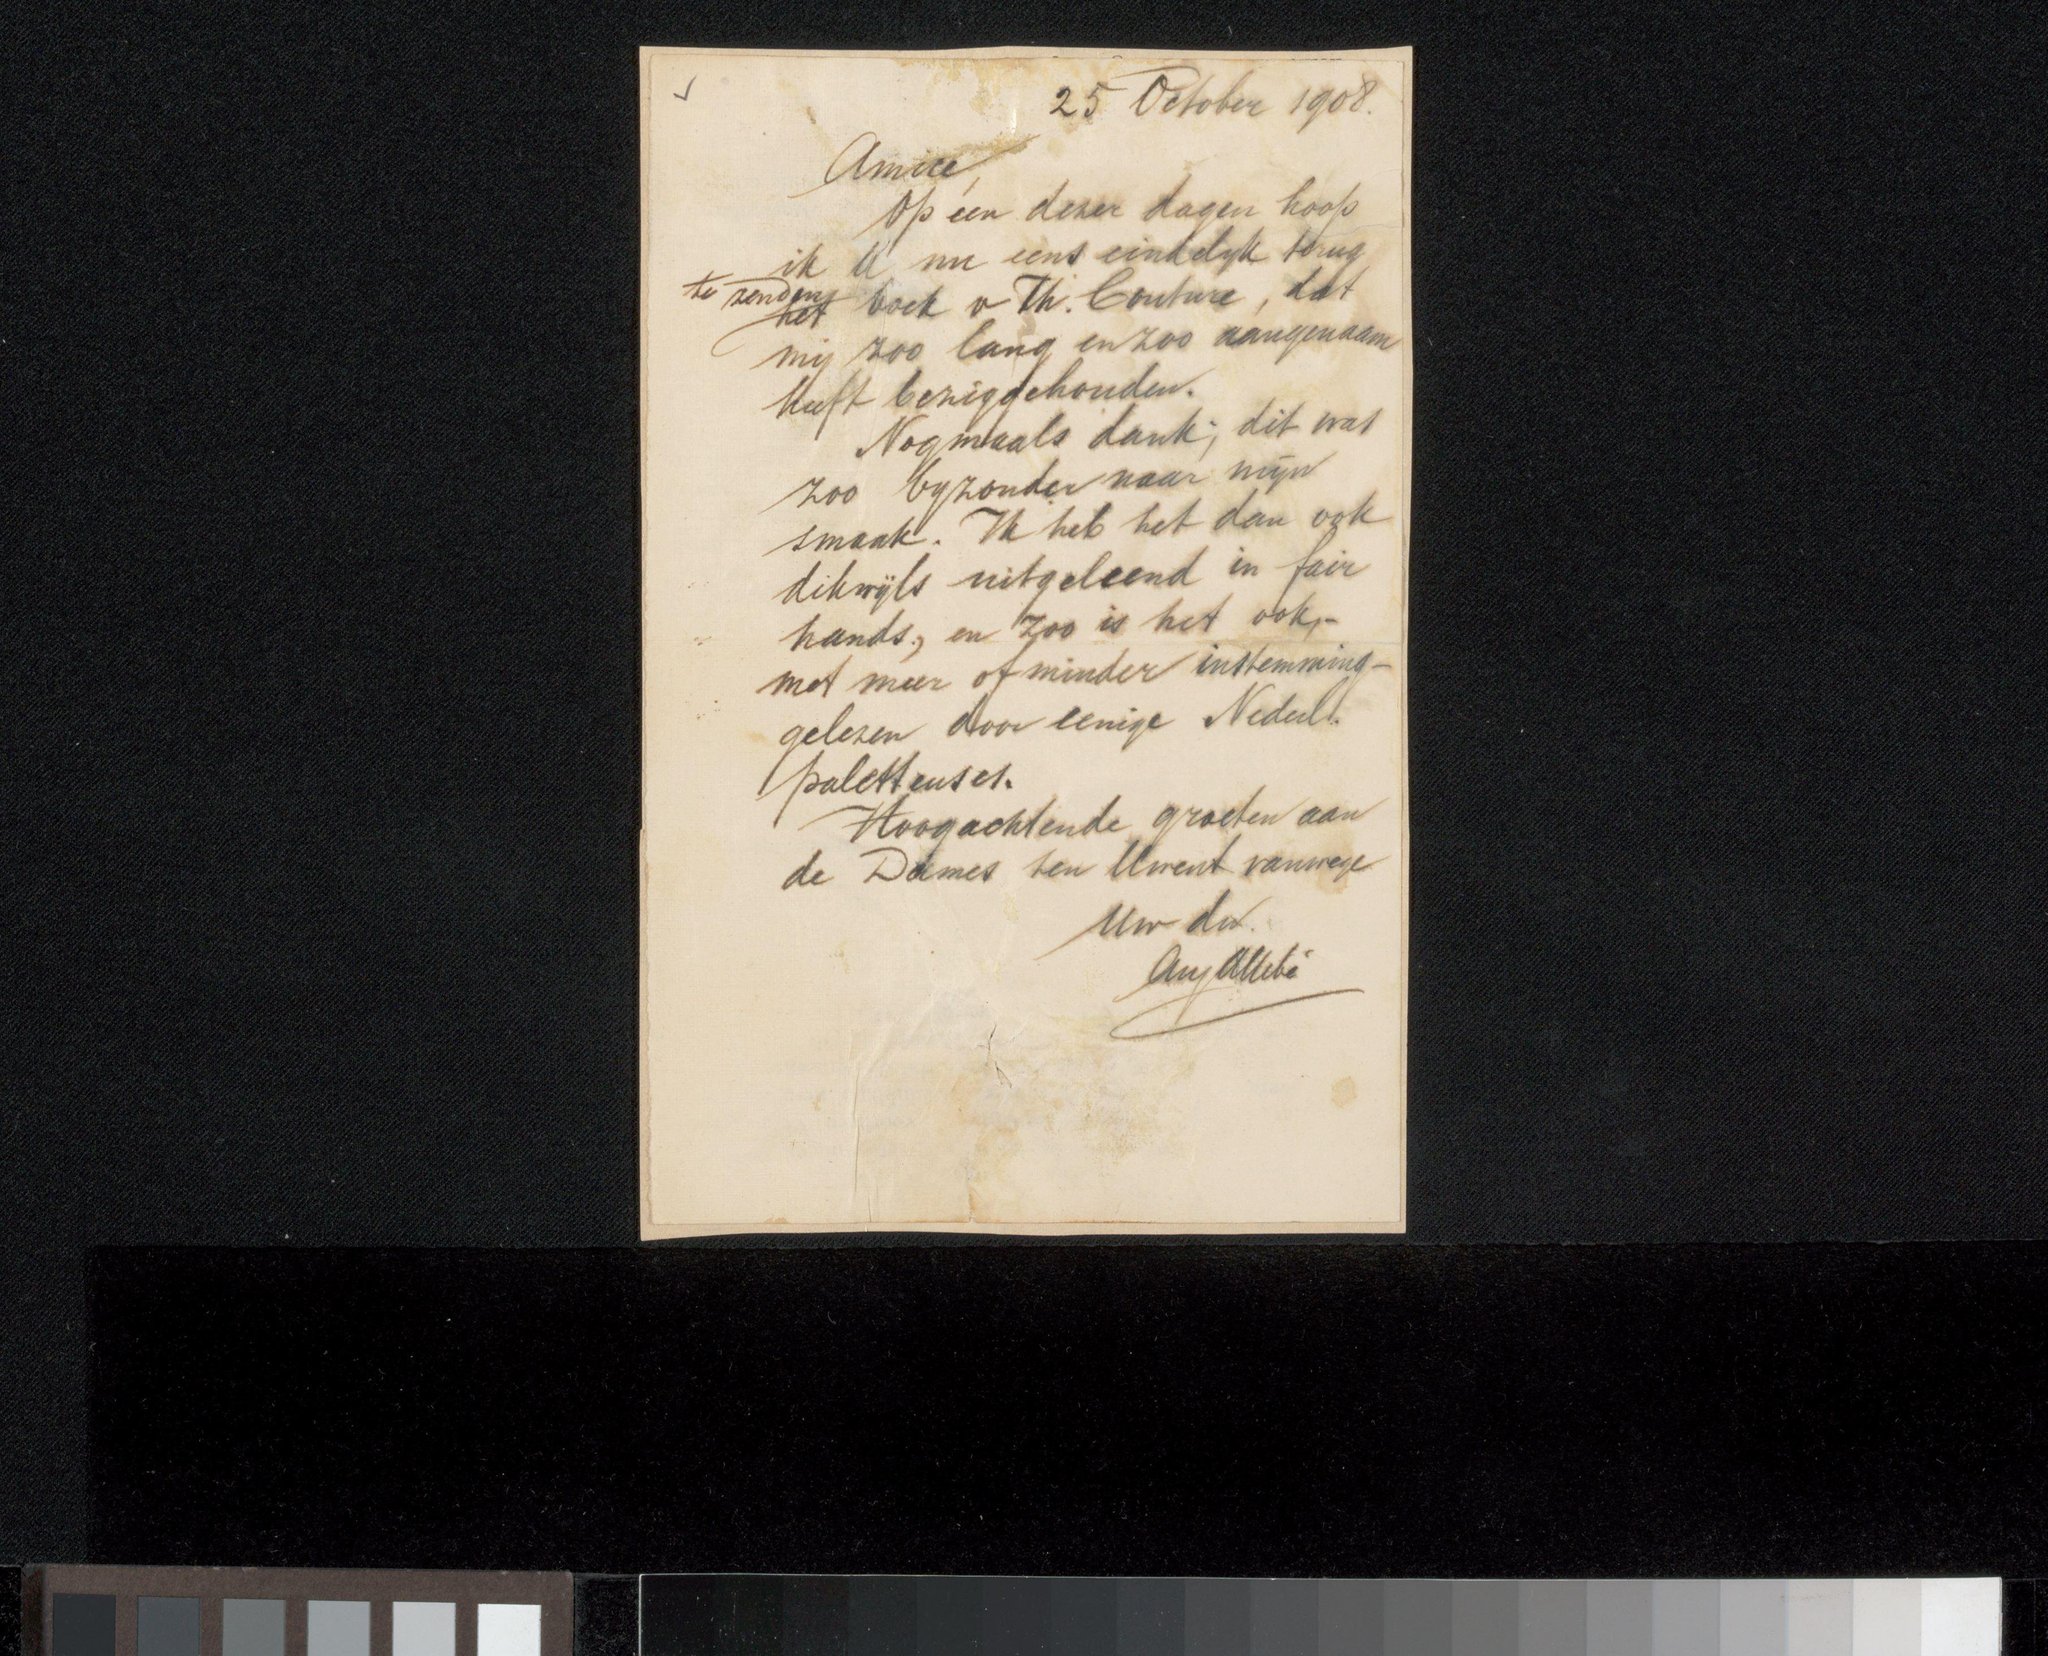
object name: letter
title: Brief aan Jan Veth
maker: august allebé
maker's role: draughtsman, print maker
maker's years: 1838-1927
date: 1908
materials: ink, paper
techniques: pen, writing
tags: dordrecht, painter, print maker, draughtsman, designer, jan veth, thomas couture, printed matter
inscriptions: collector's mark: ‘RPK’